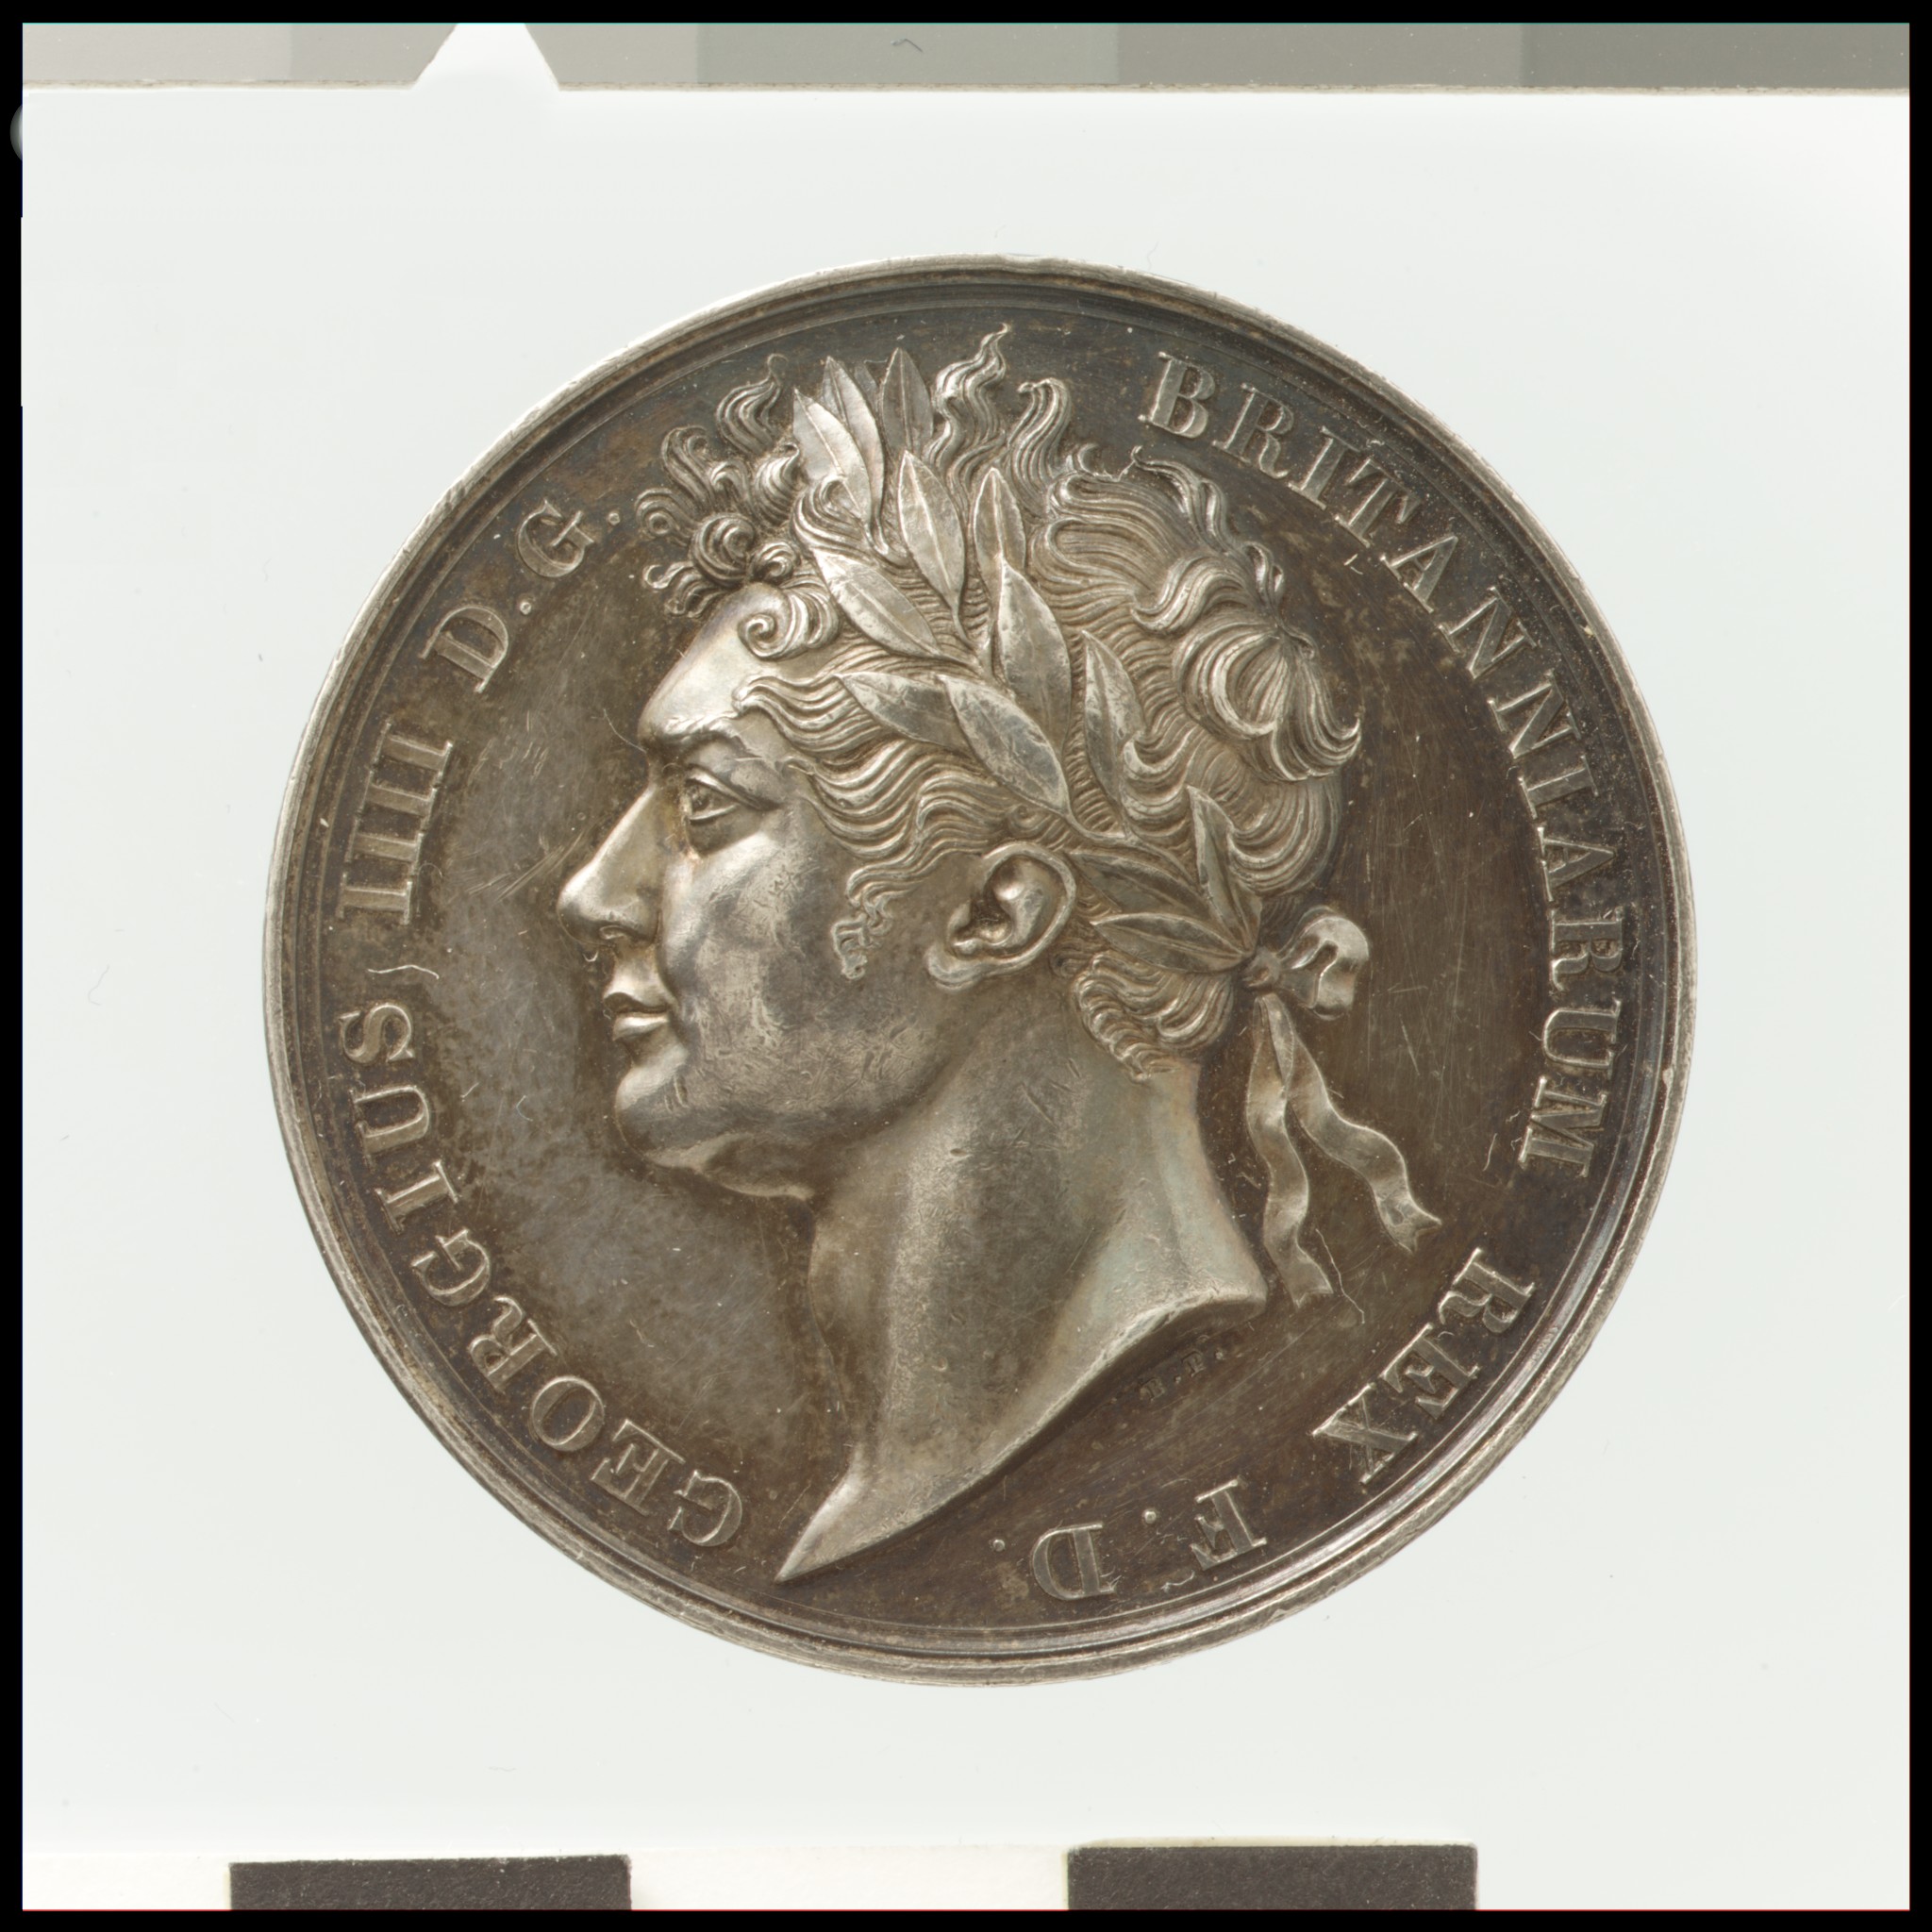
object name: medal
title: Coronation of George IV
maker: benedetto pistrucci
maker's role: maker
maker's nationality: italian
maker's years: 1783-1855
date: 1821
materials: silver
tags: men,profiles,angels